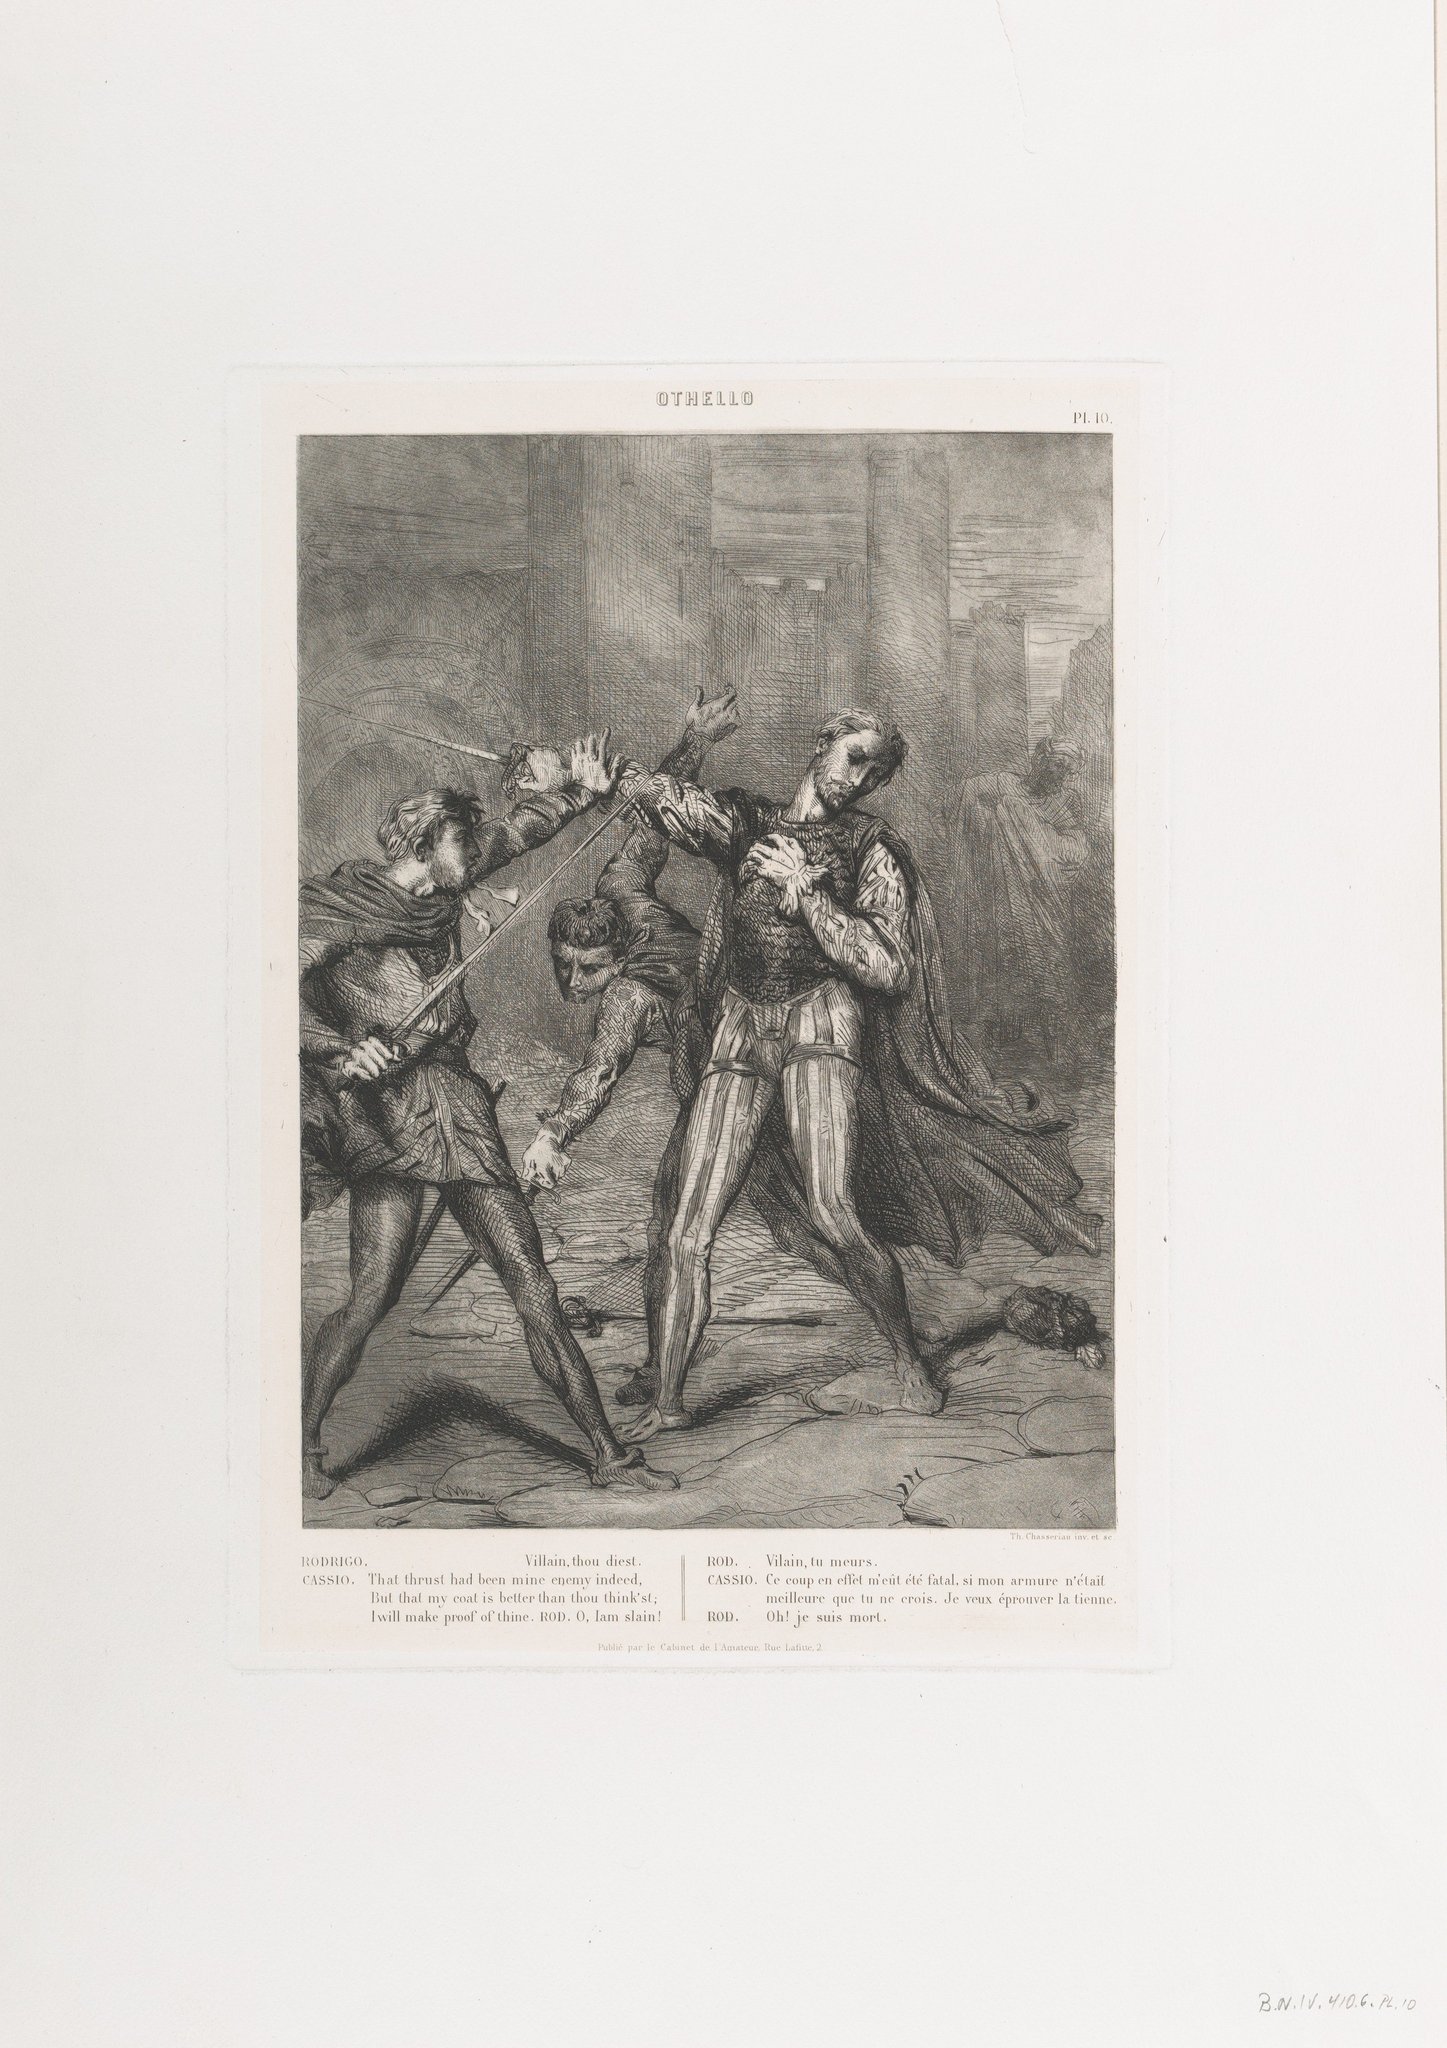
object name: print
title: "Villain, thou diest": plate 10 from Othello (Act 5, Scene 1)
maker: théodore chassériau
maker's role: artist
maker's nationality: french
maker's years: 1819-1856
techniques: aquatint, printmaking, engraving, etching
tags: swords,shakespeare,men